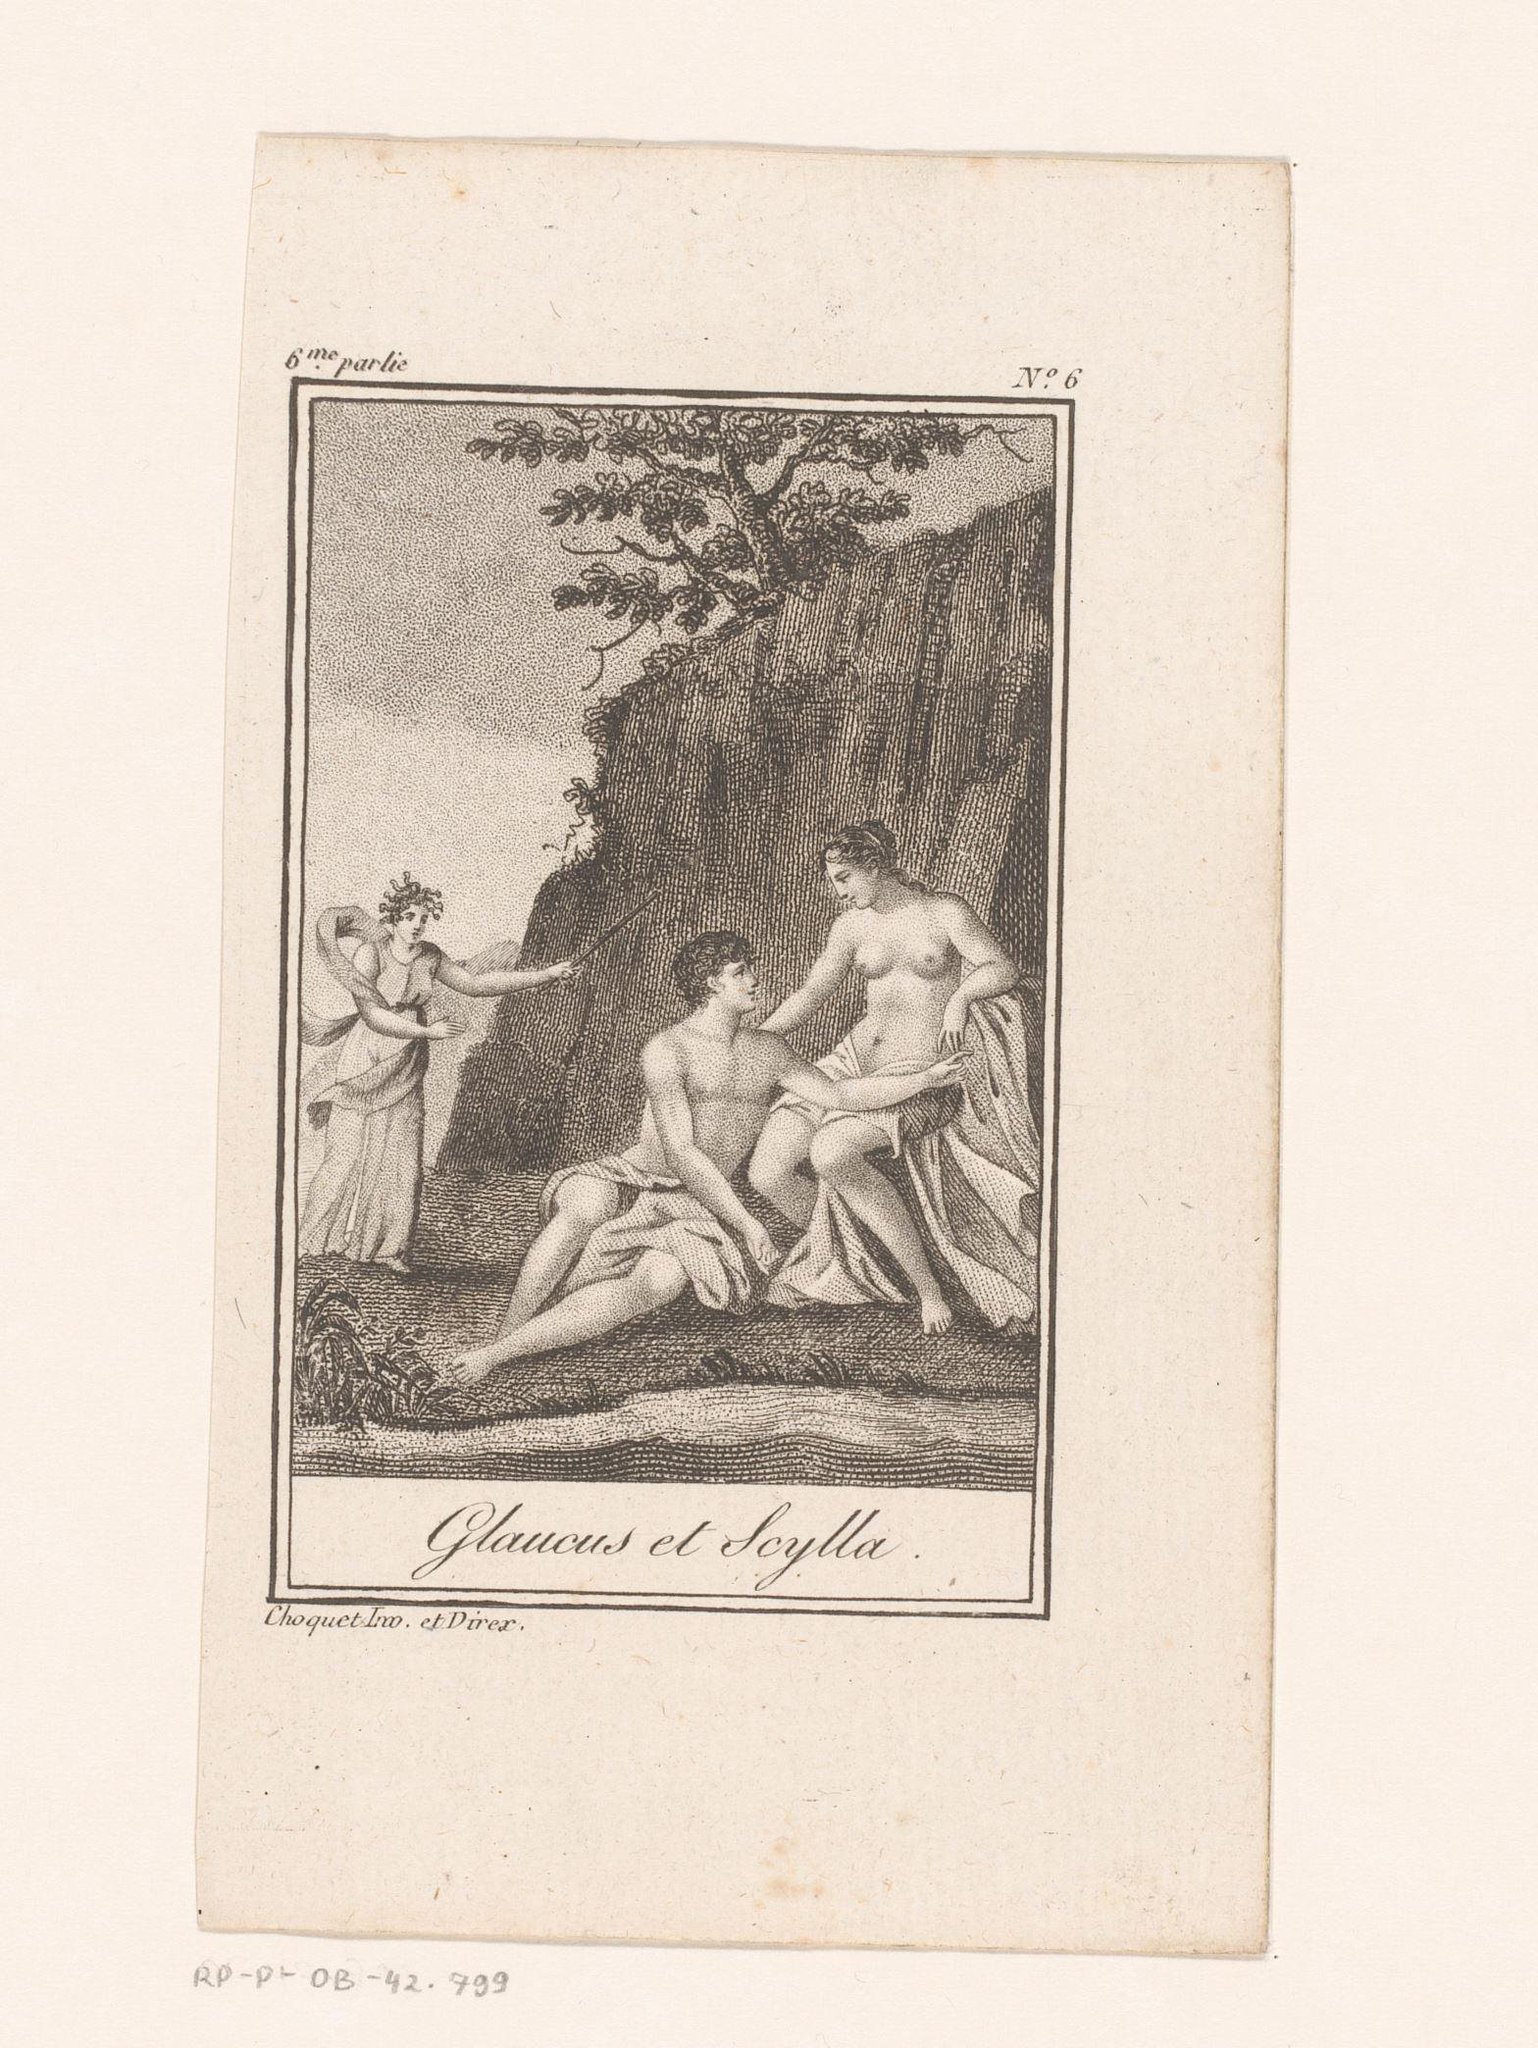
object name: print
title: Glaucus en Scylla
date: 1784-1824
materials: paper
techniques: engraving, etching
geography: france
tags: love-affairs of glaucus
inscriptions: collector's mark: Lugt 2228